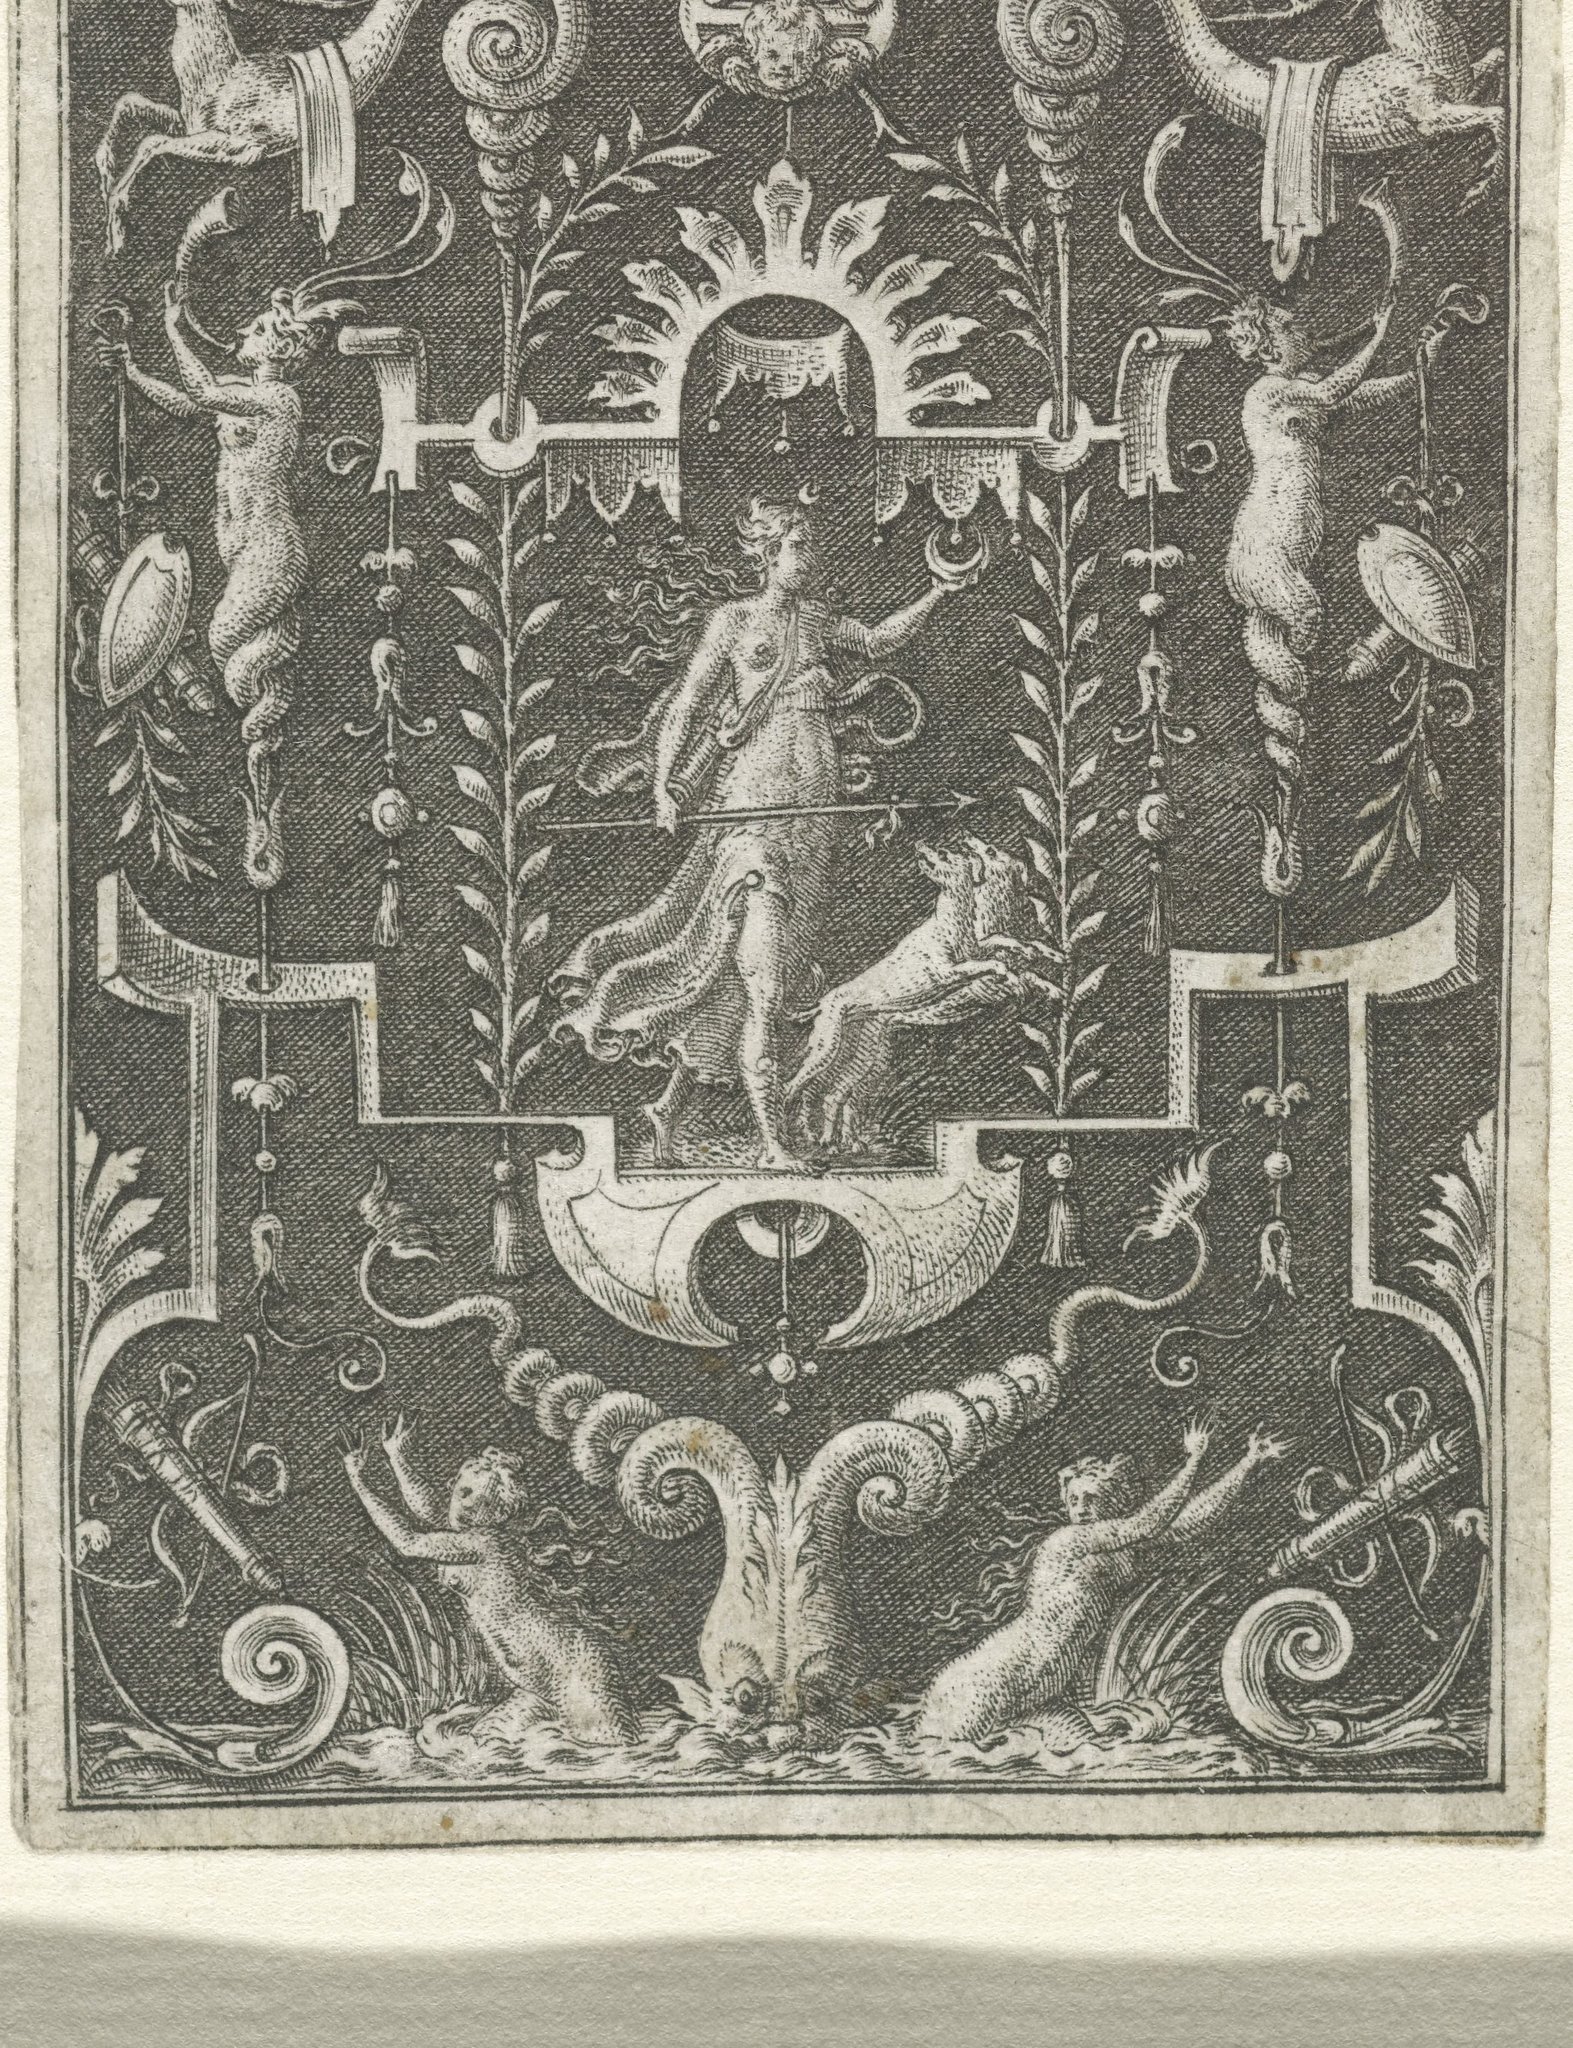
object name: print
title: Diana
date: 1528-1583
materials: paper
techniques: engraving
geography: france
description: Diana, met de maansikkel in de hand, geflankeerd door twee hermen met dubbele, in elkaar gedraaide staarten. Uit serie van 6 bladen.